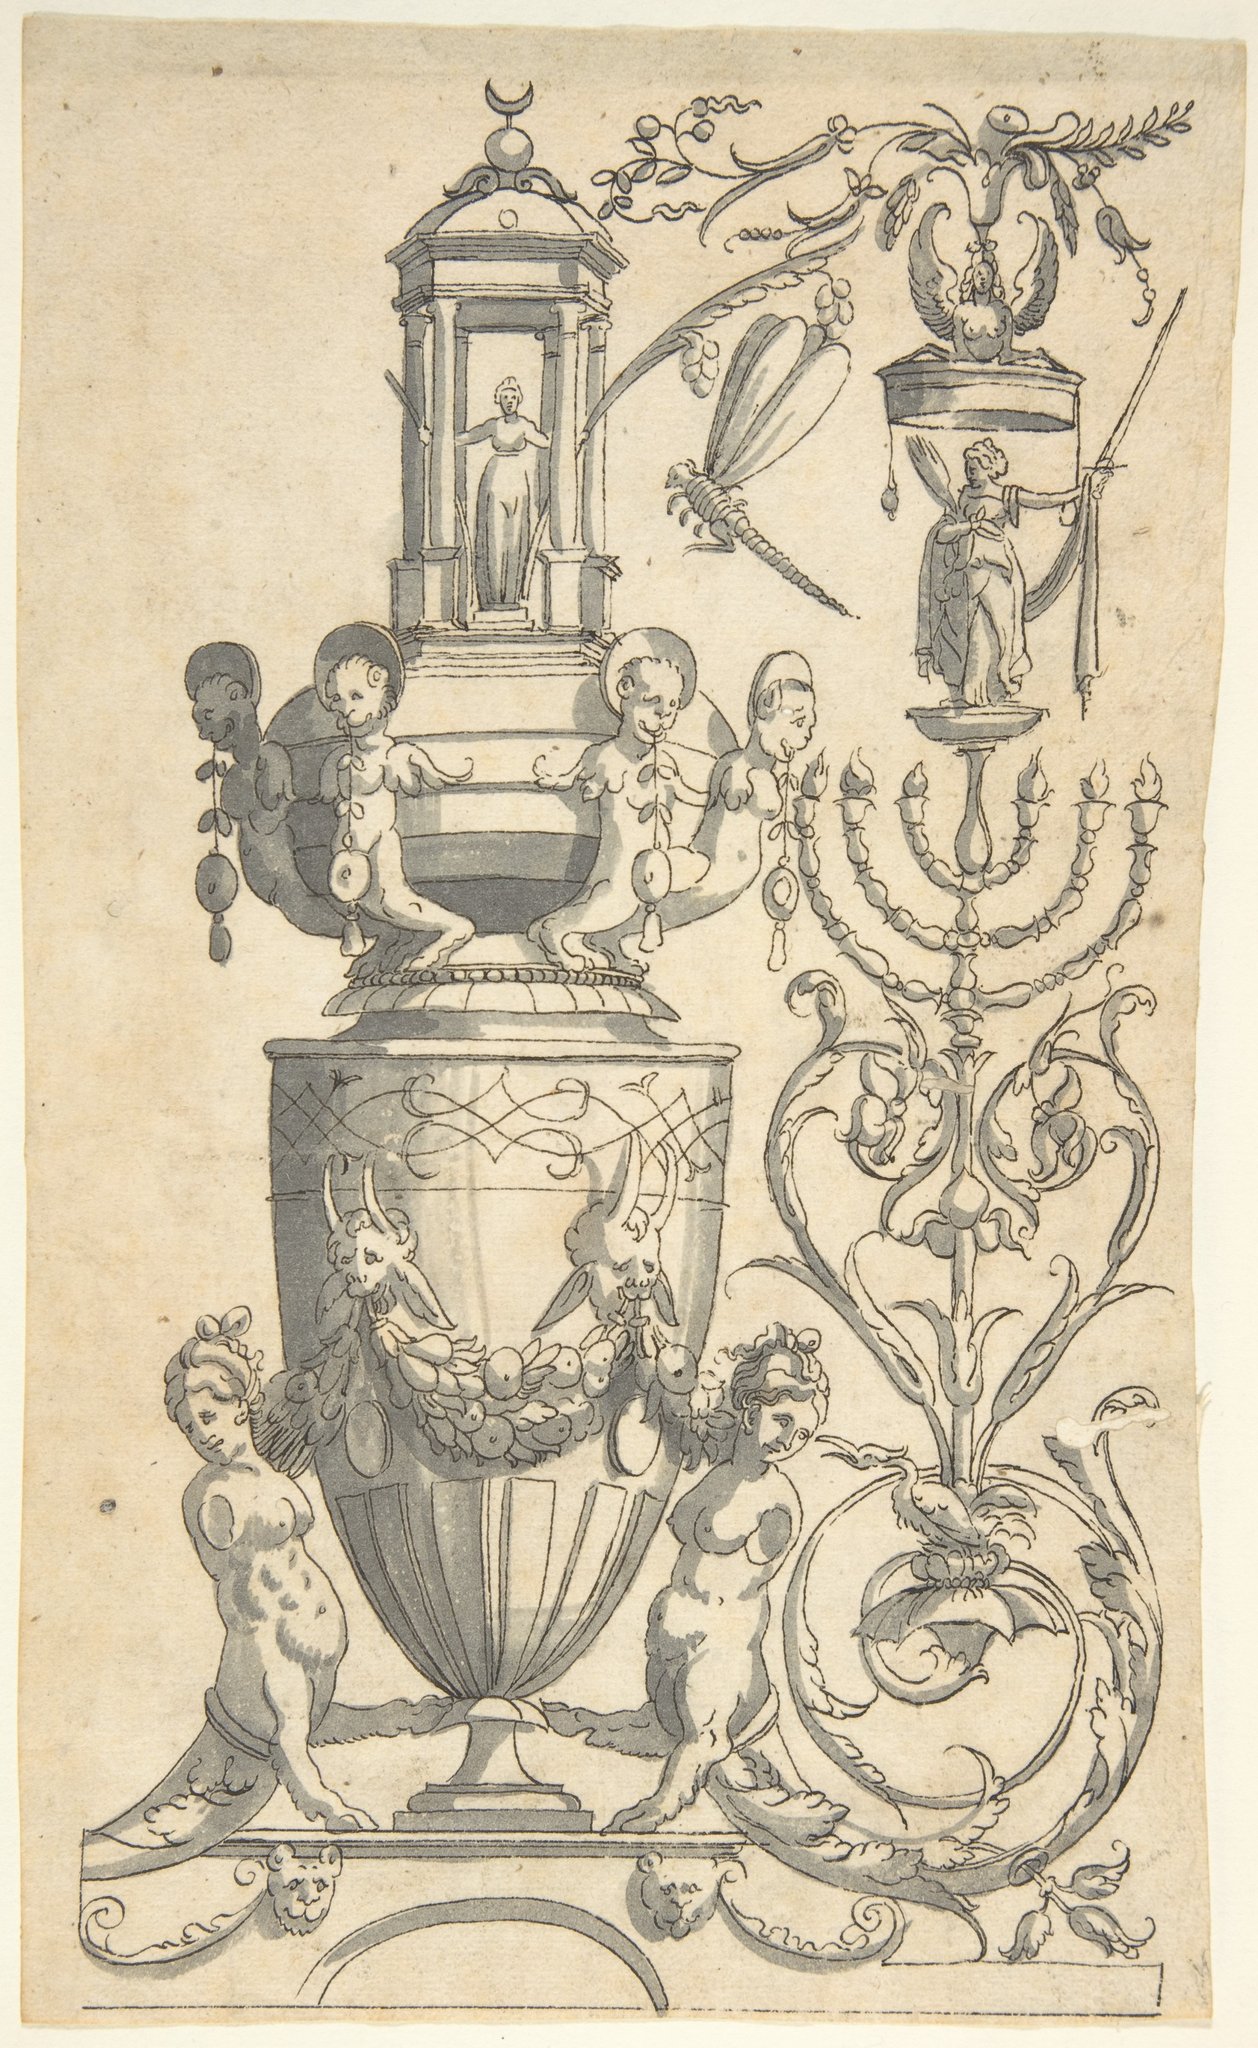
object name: ornament architecture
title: Candelabra Grotesque with a Large Vase Flanked by Sphinxes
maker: anonymous, italian, 16th century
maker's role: artist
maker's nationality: italian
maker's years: 1500-1600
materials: ink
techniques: brush, pen, wash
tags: grotesques,ornament,mythical creatures,sphinx,vases